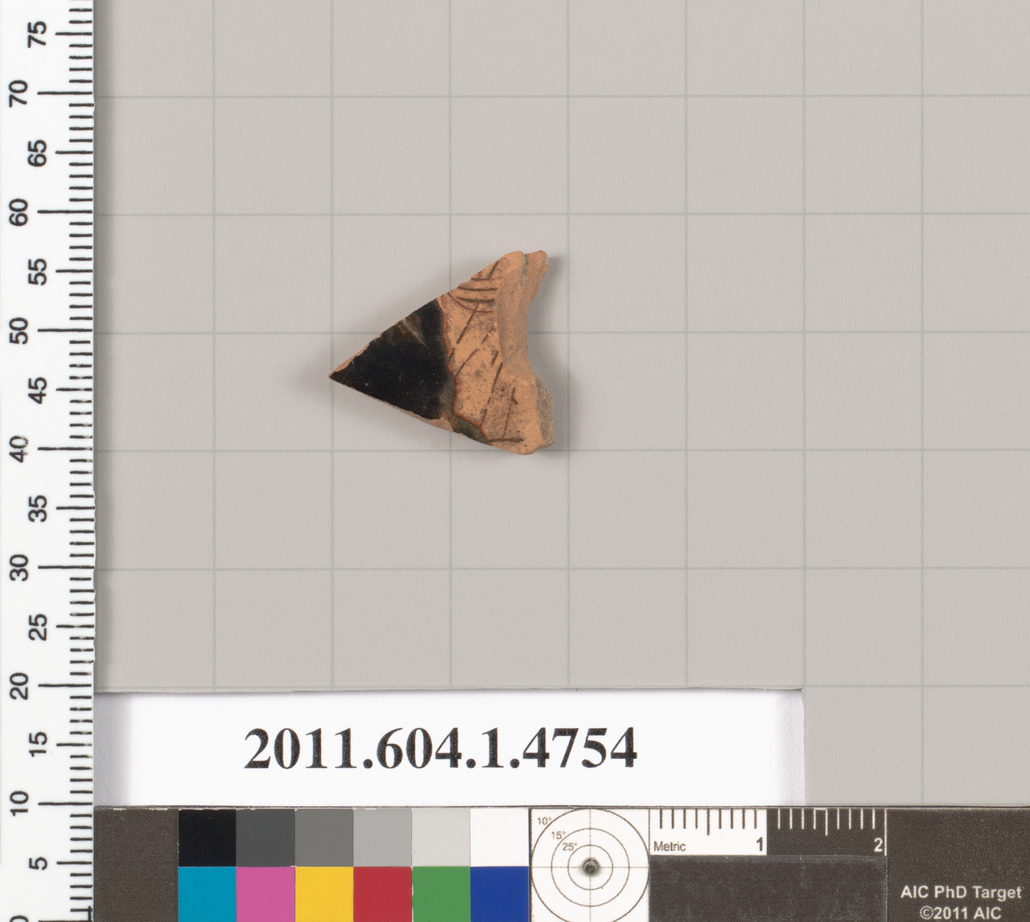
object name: kylix fragment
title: Terracotta fragment of a kylix (drinking cup)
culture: greek, attic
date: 490-480 BCE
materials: terracotta